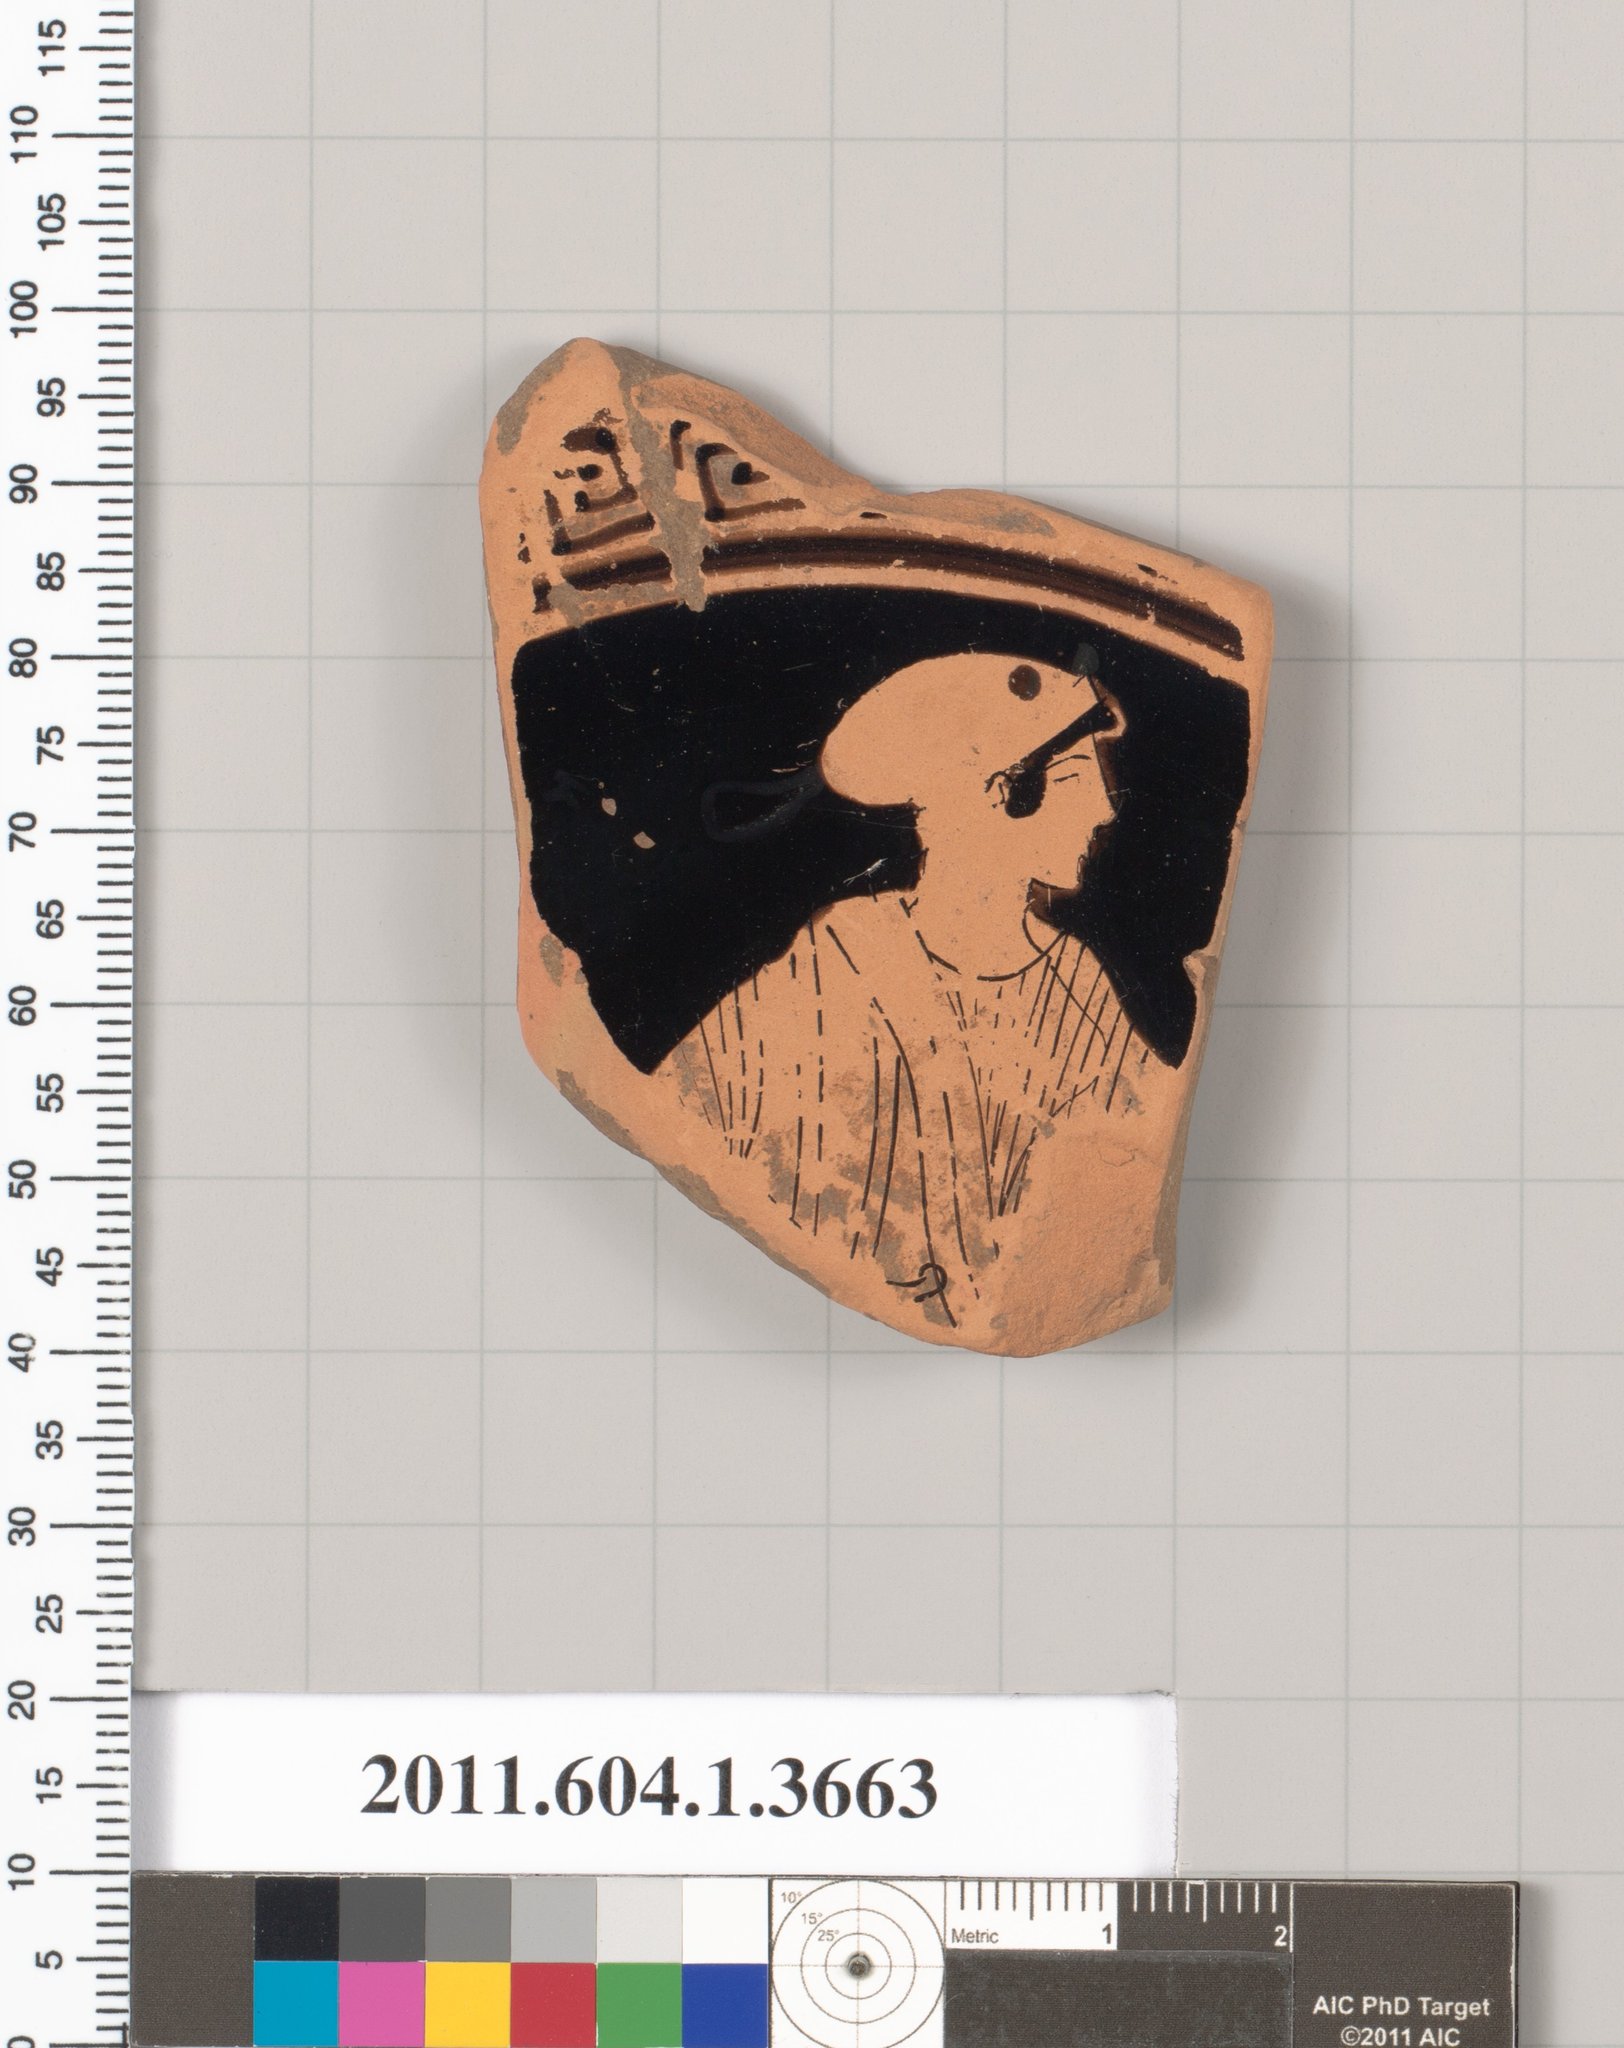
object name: kylix fragment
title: Terracotta fragment of a kylix (drinking cup)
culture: greek, attic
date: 490-470 BCE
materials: terracotta